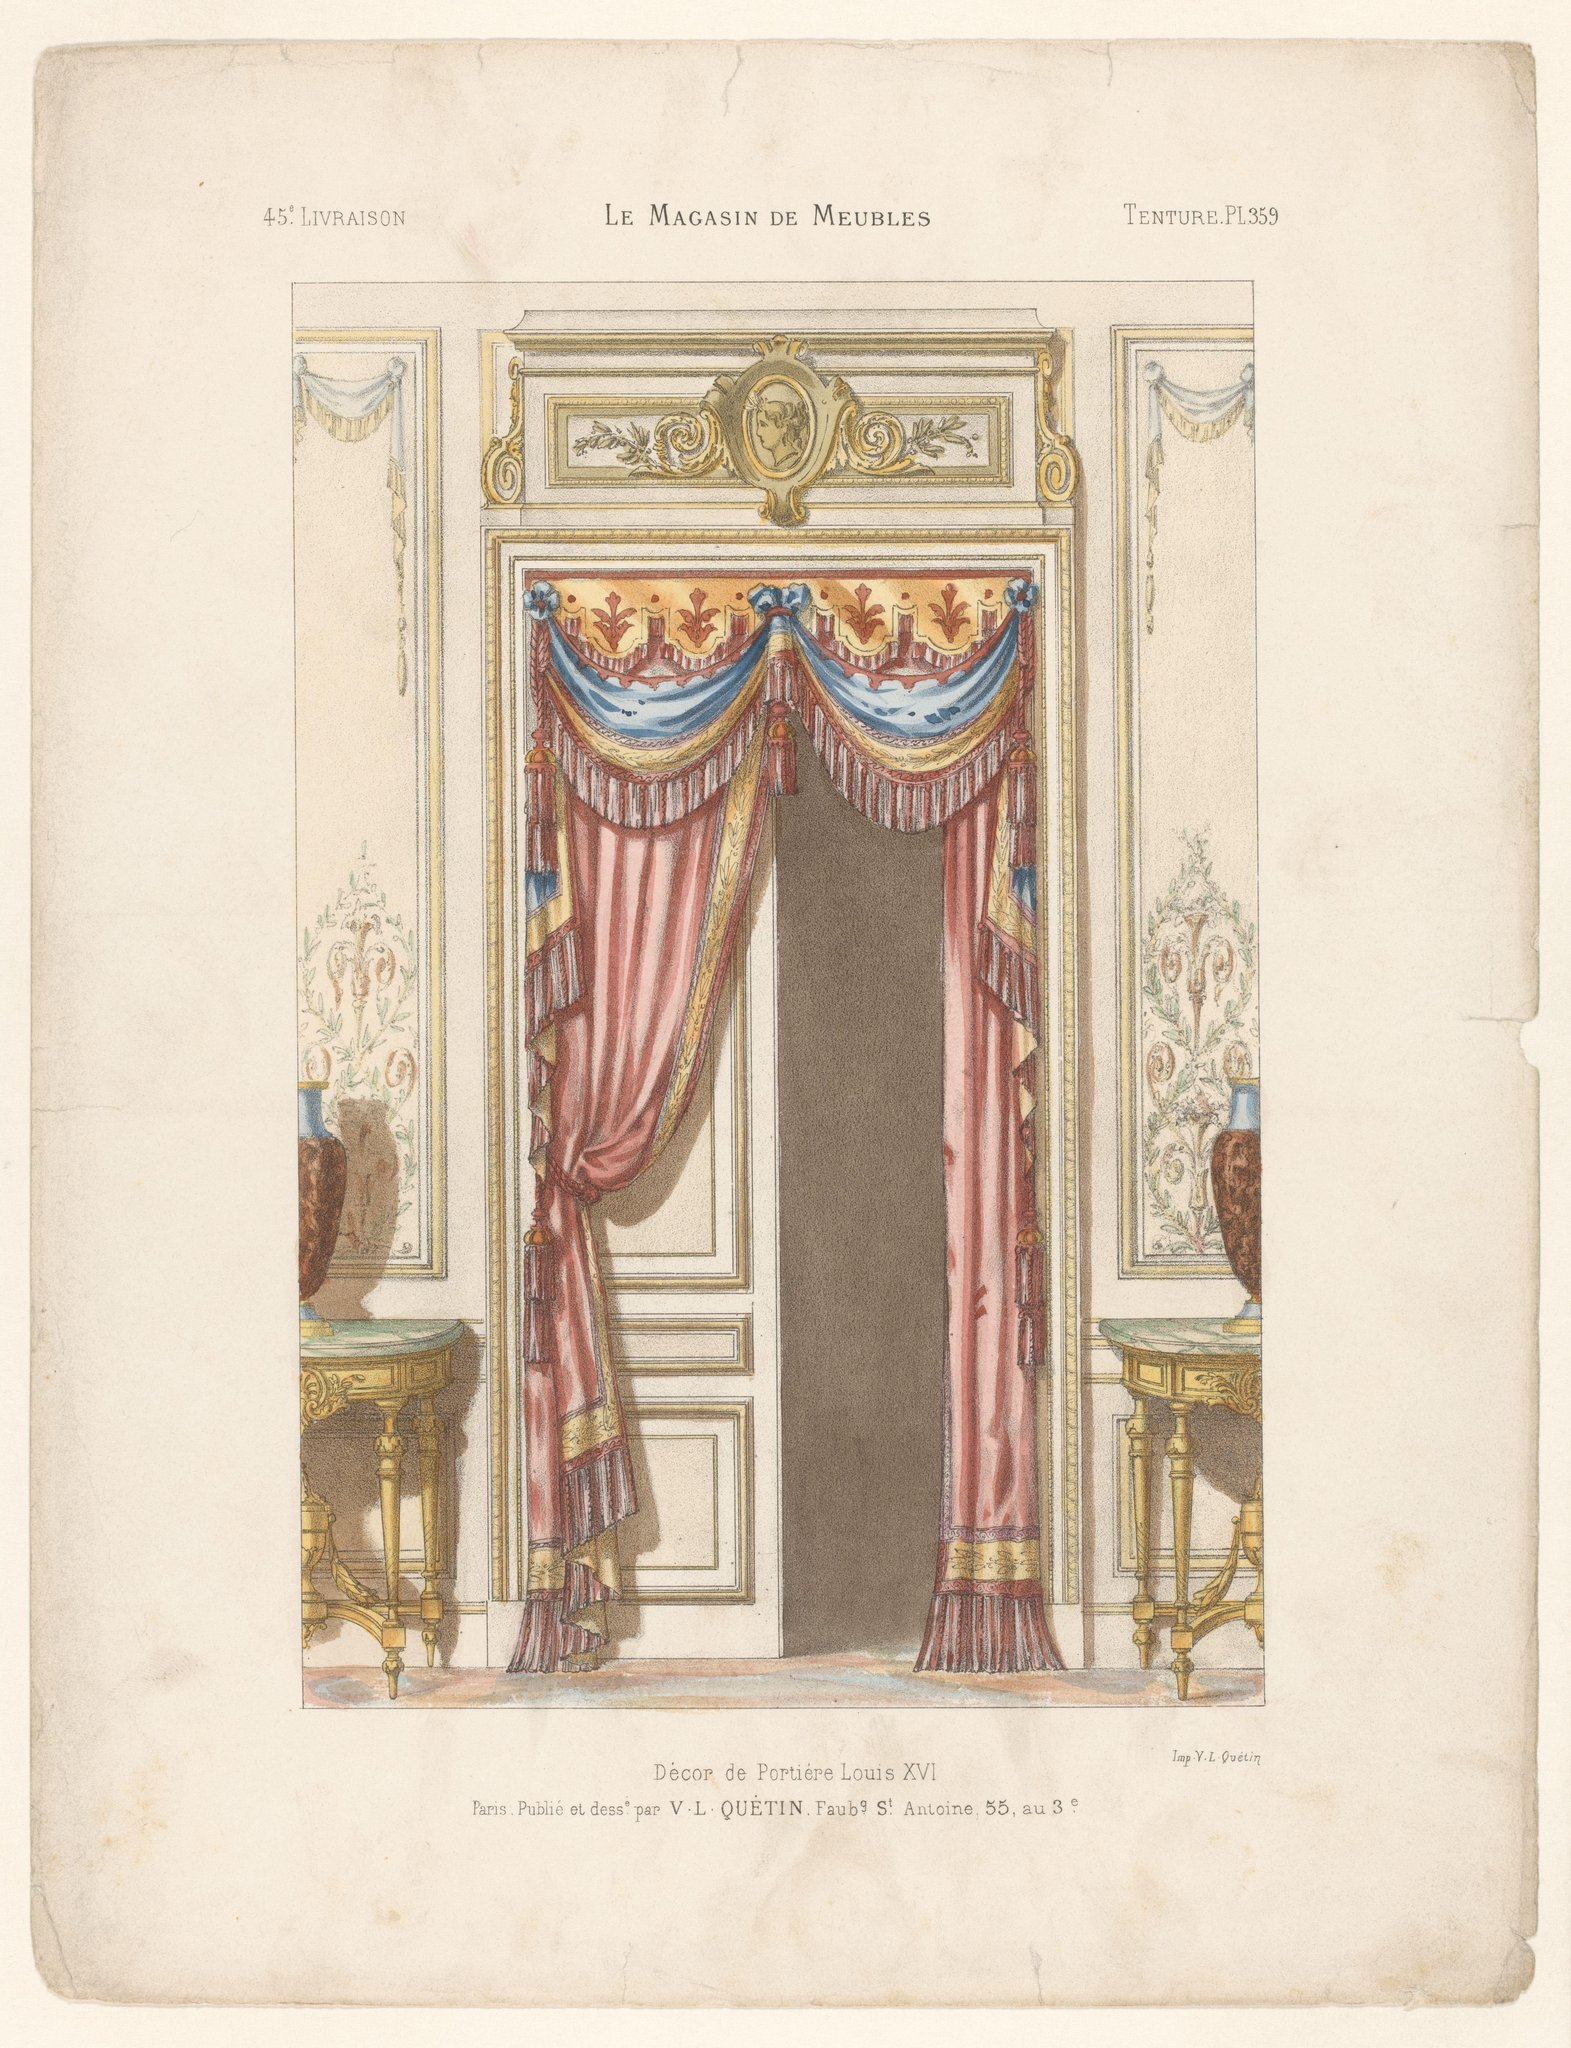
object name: print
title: Décor de Portière Louis XVI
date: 1878-1904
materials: paper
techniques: hand coloring, lithograph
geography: paris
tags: door, hangings and drapery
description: Een deur met gedrapeerde gordijnen in de Lodewijk XVI-stijl. Prent uit 45e Livraison.